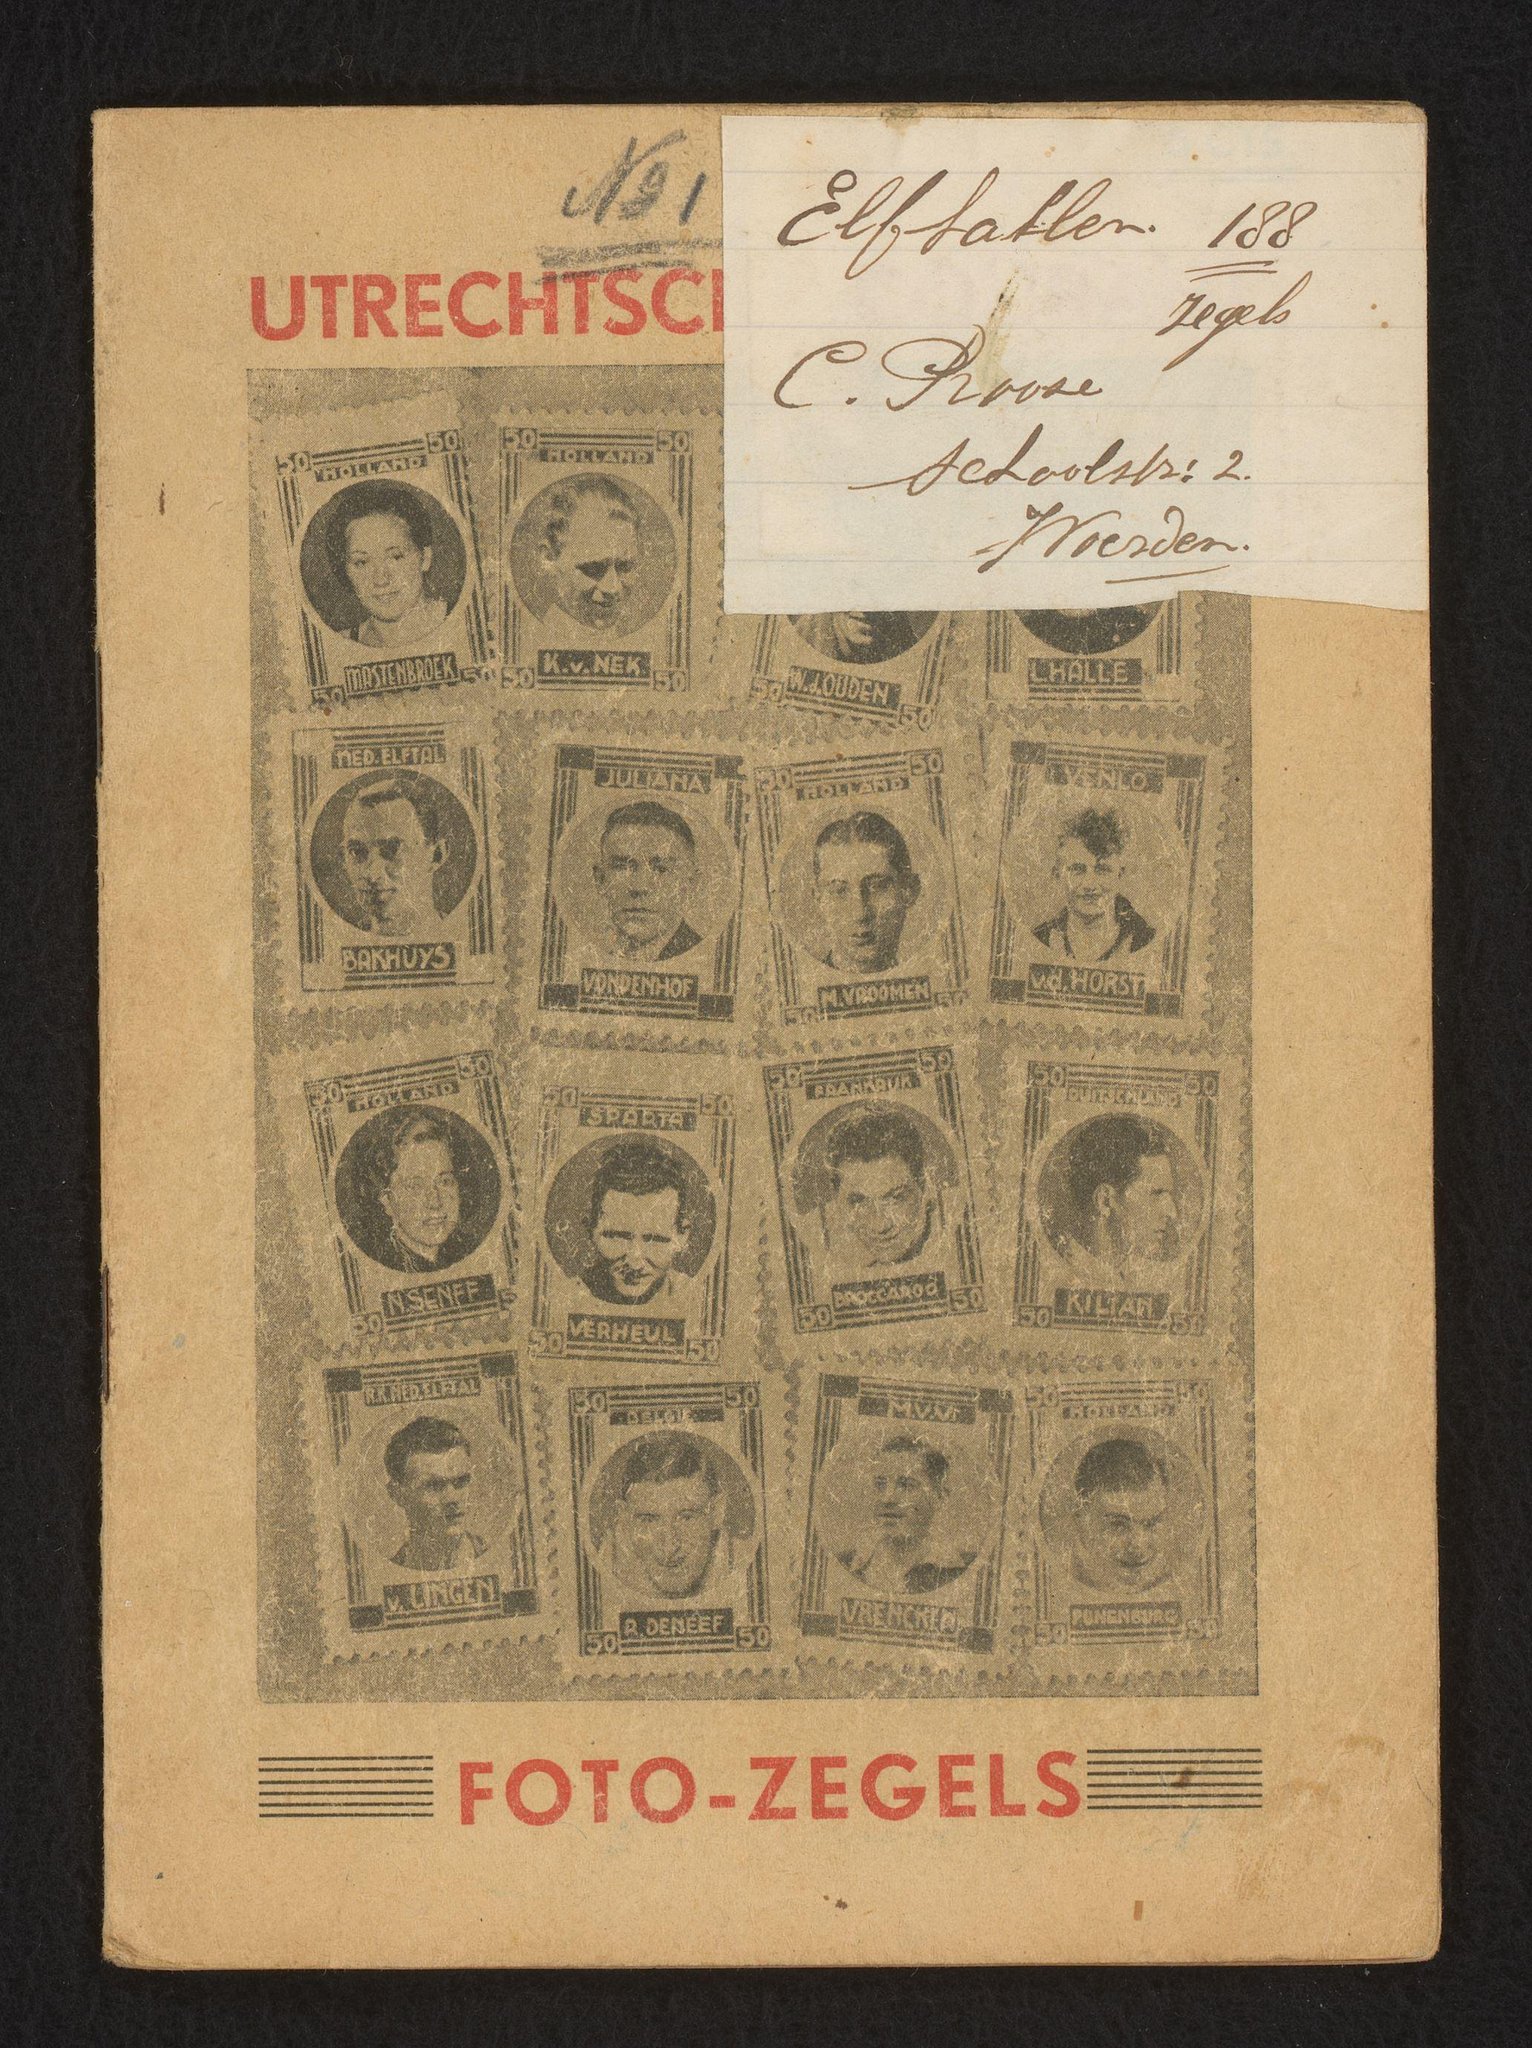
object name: photograph album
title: Utrechtse Courant Foto-Zegels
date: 1937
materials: paper, photographic support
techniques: gelatin silver print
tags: utrecht, bernhard (prins der nederlanden), the hague, juliana of the netherlands, soccer, football (early names: soule, choule, cholle) (+ sportsman, player, etc.), historical persons, ruler, sovereign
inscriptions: annotation: ‘Elftallen 188/ zegels/ C. Rooze. Schoolstr 2/ Woerden’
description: Plakboek met 195 fotozegels van onder andere Prinses Juliana en Prins Bernhard, ter gelegenheid van hun huwelijk op 7 januari 1937, en verschillende bekende sporters. De zegels werden verspreid bij de Utrechtse Courant.